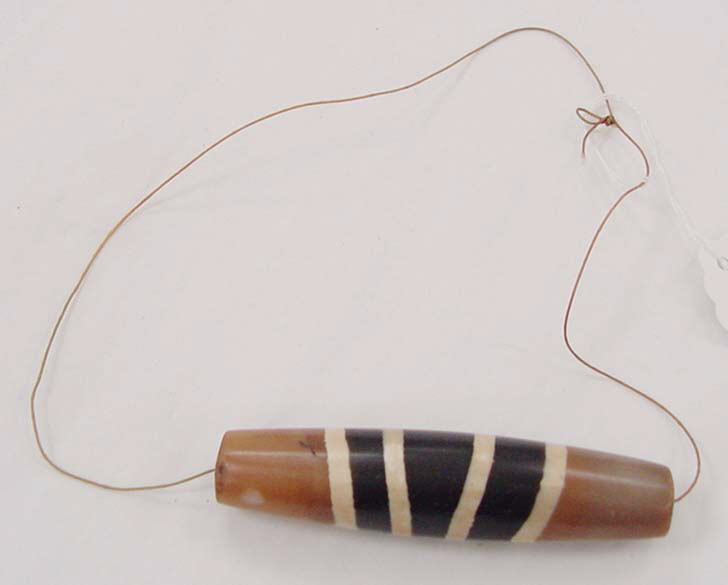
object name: necklace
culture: tibetan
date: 1801-1900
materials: cotton, stone